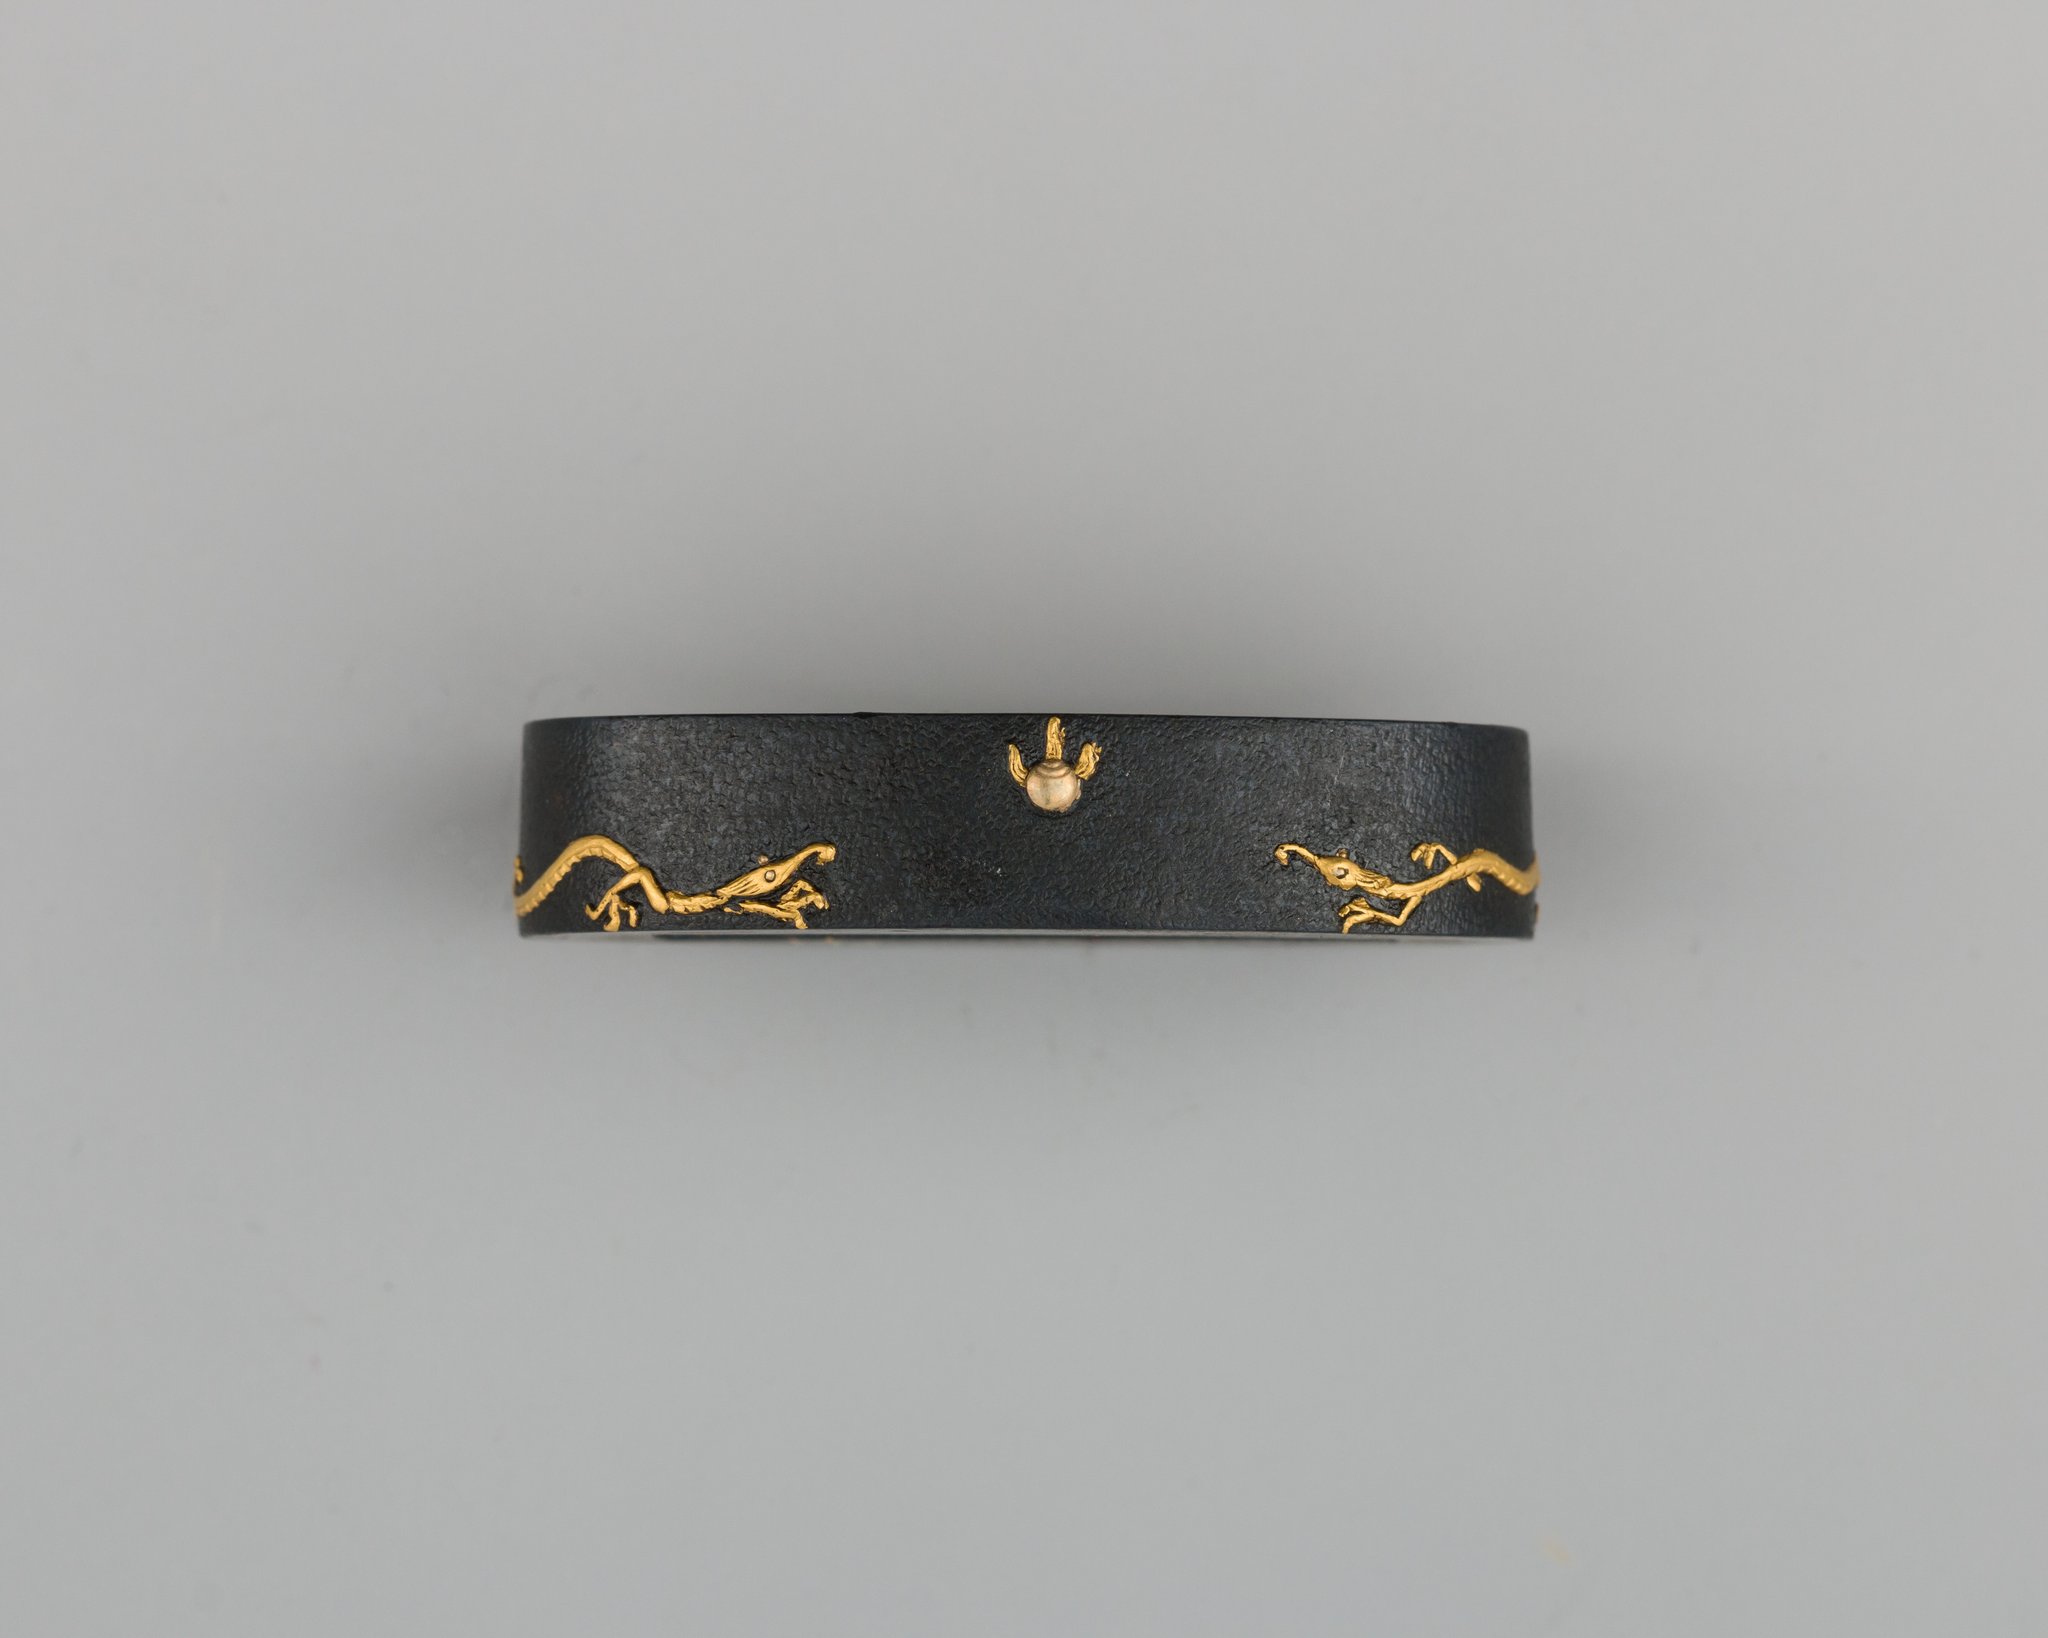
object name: sword hilt collar fuchi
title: Sword-Hilt Collar (Fuchi)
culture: japanese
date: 1615-1868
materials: gold alloy, gold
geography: japan